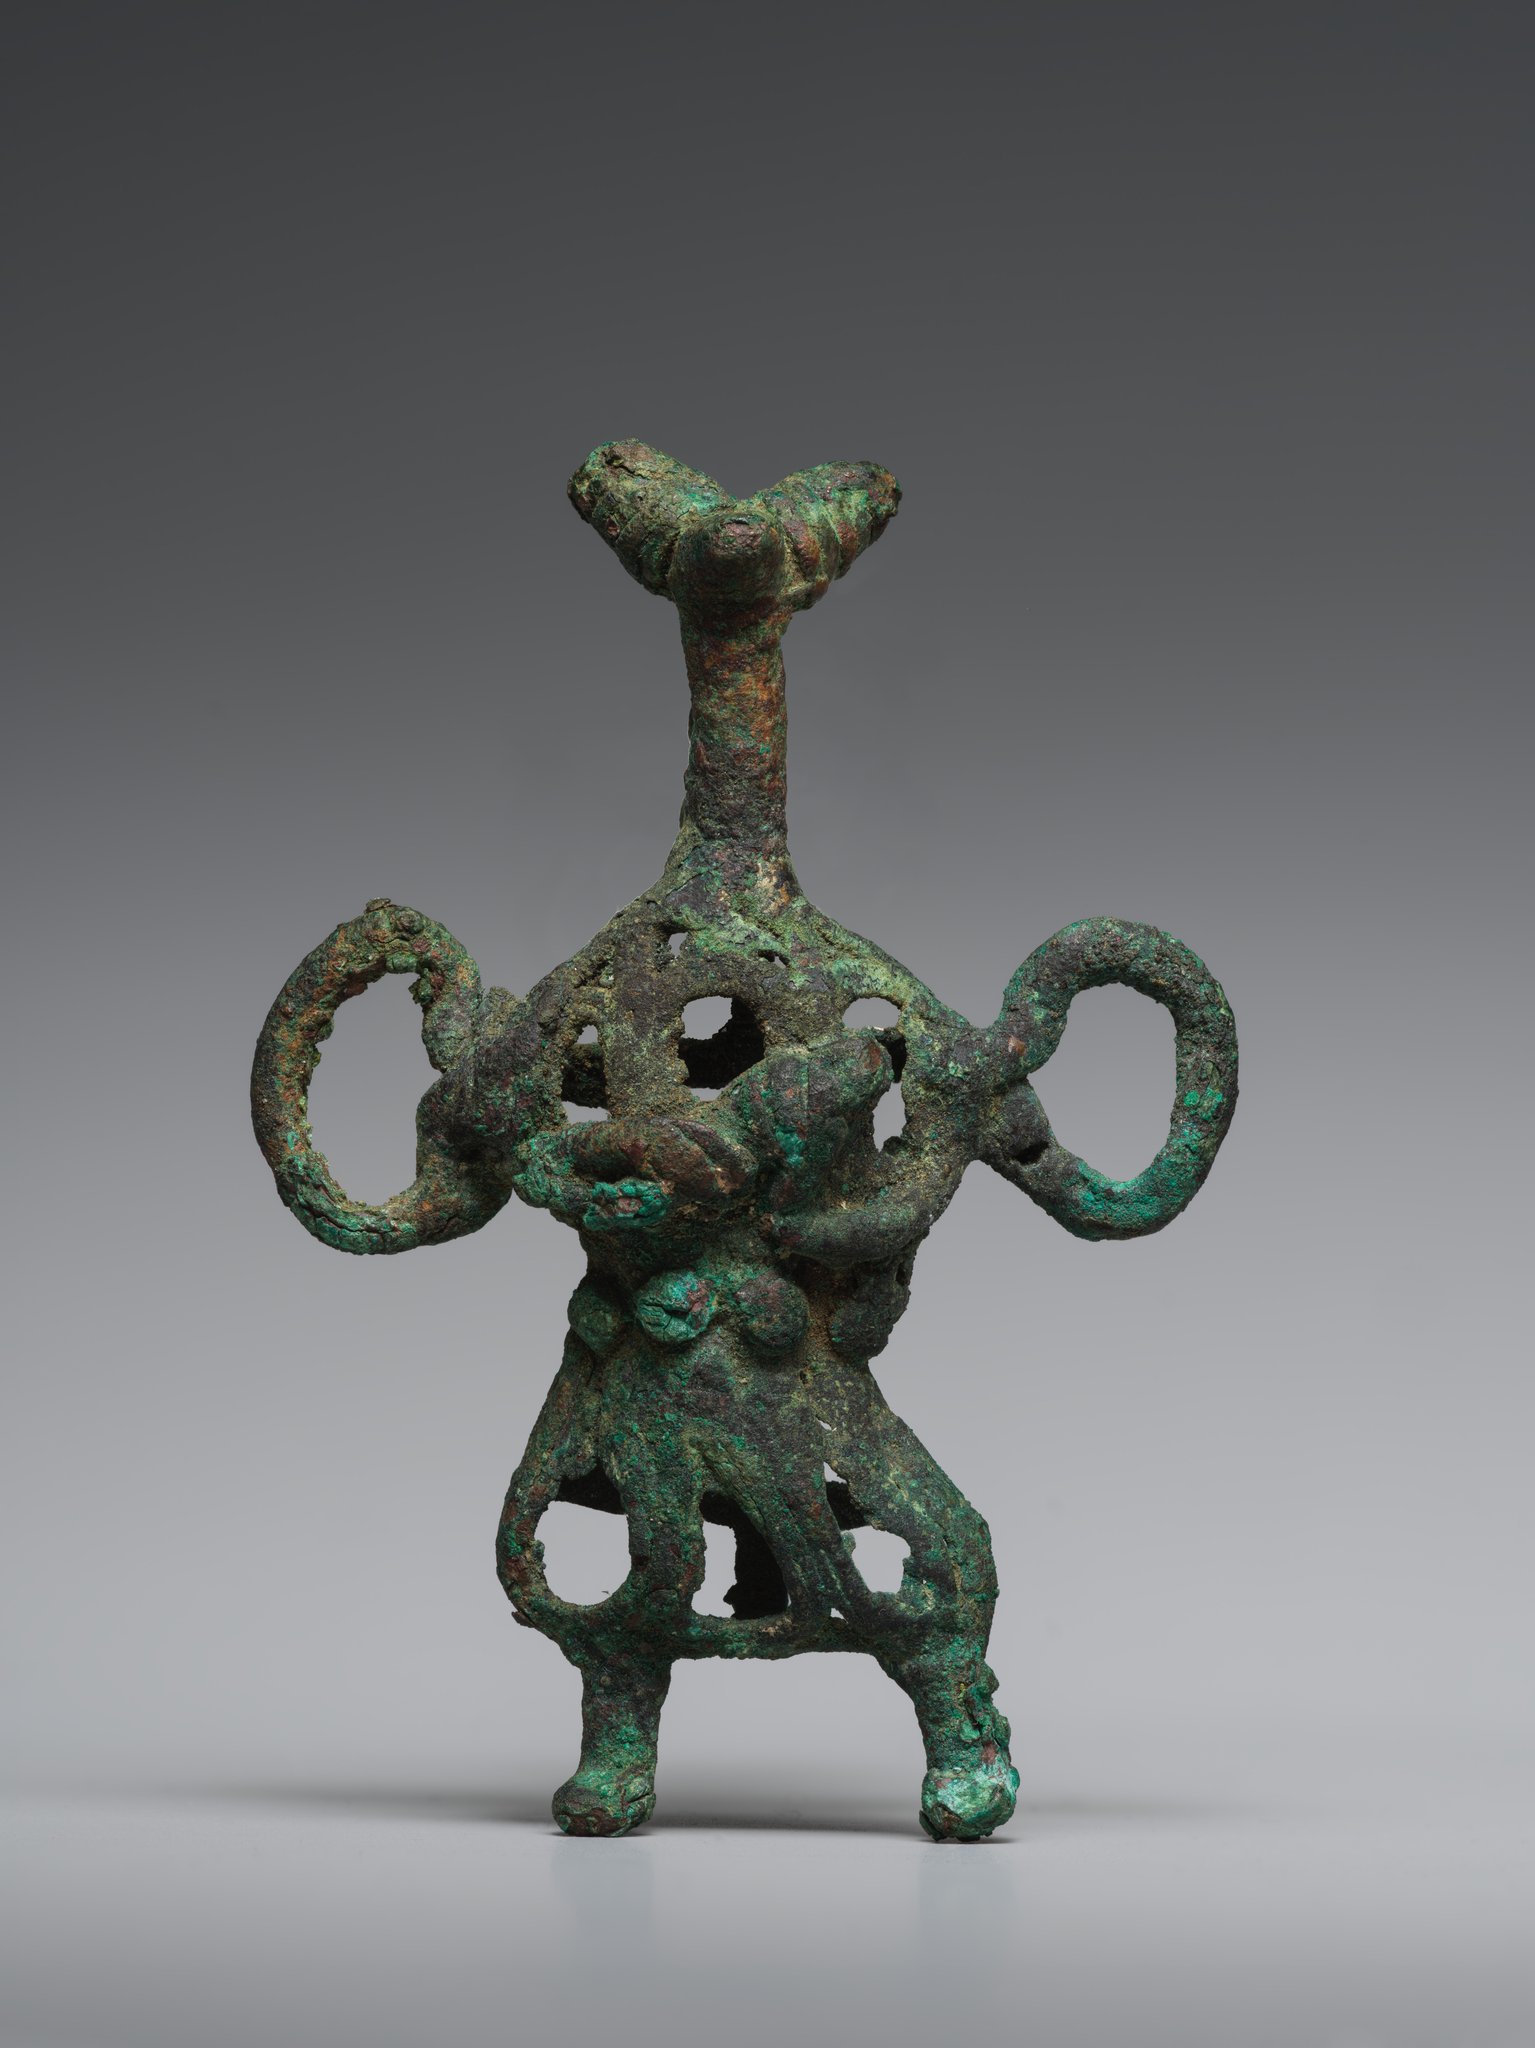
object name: pendant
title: Figurine pendant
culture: iranian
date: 1000-1 BCE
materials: bronze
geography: northwestern iran